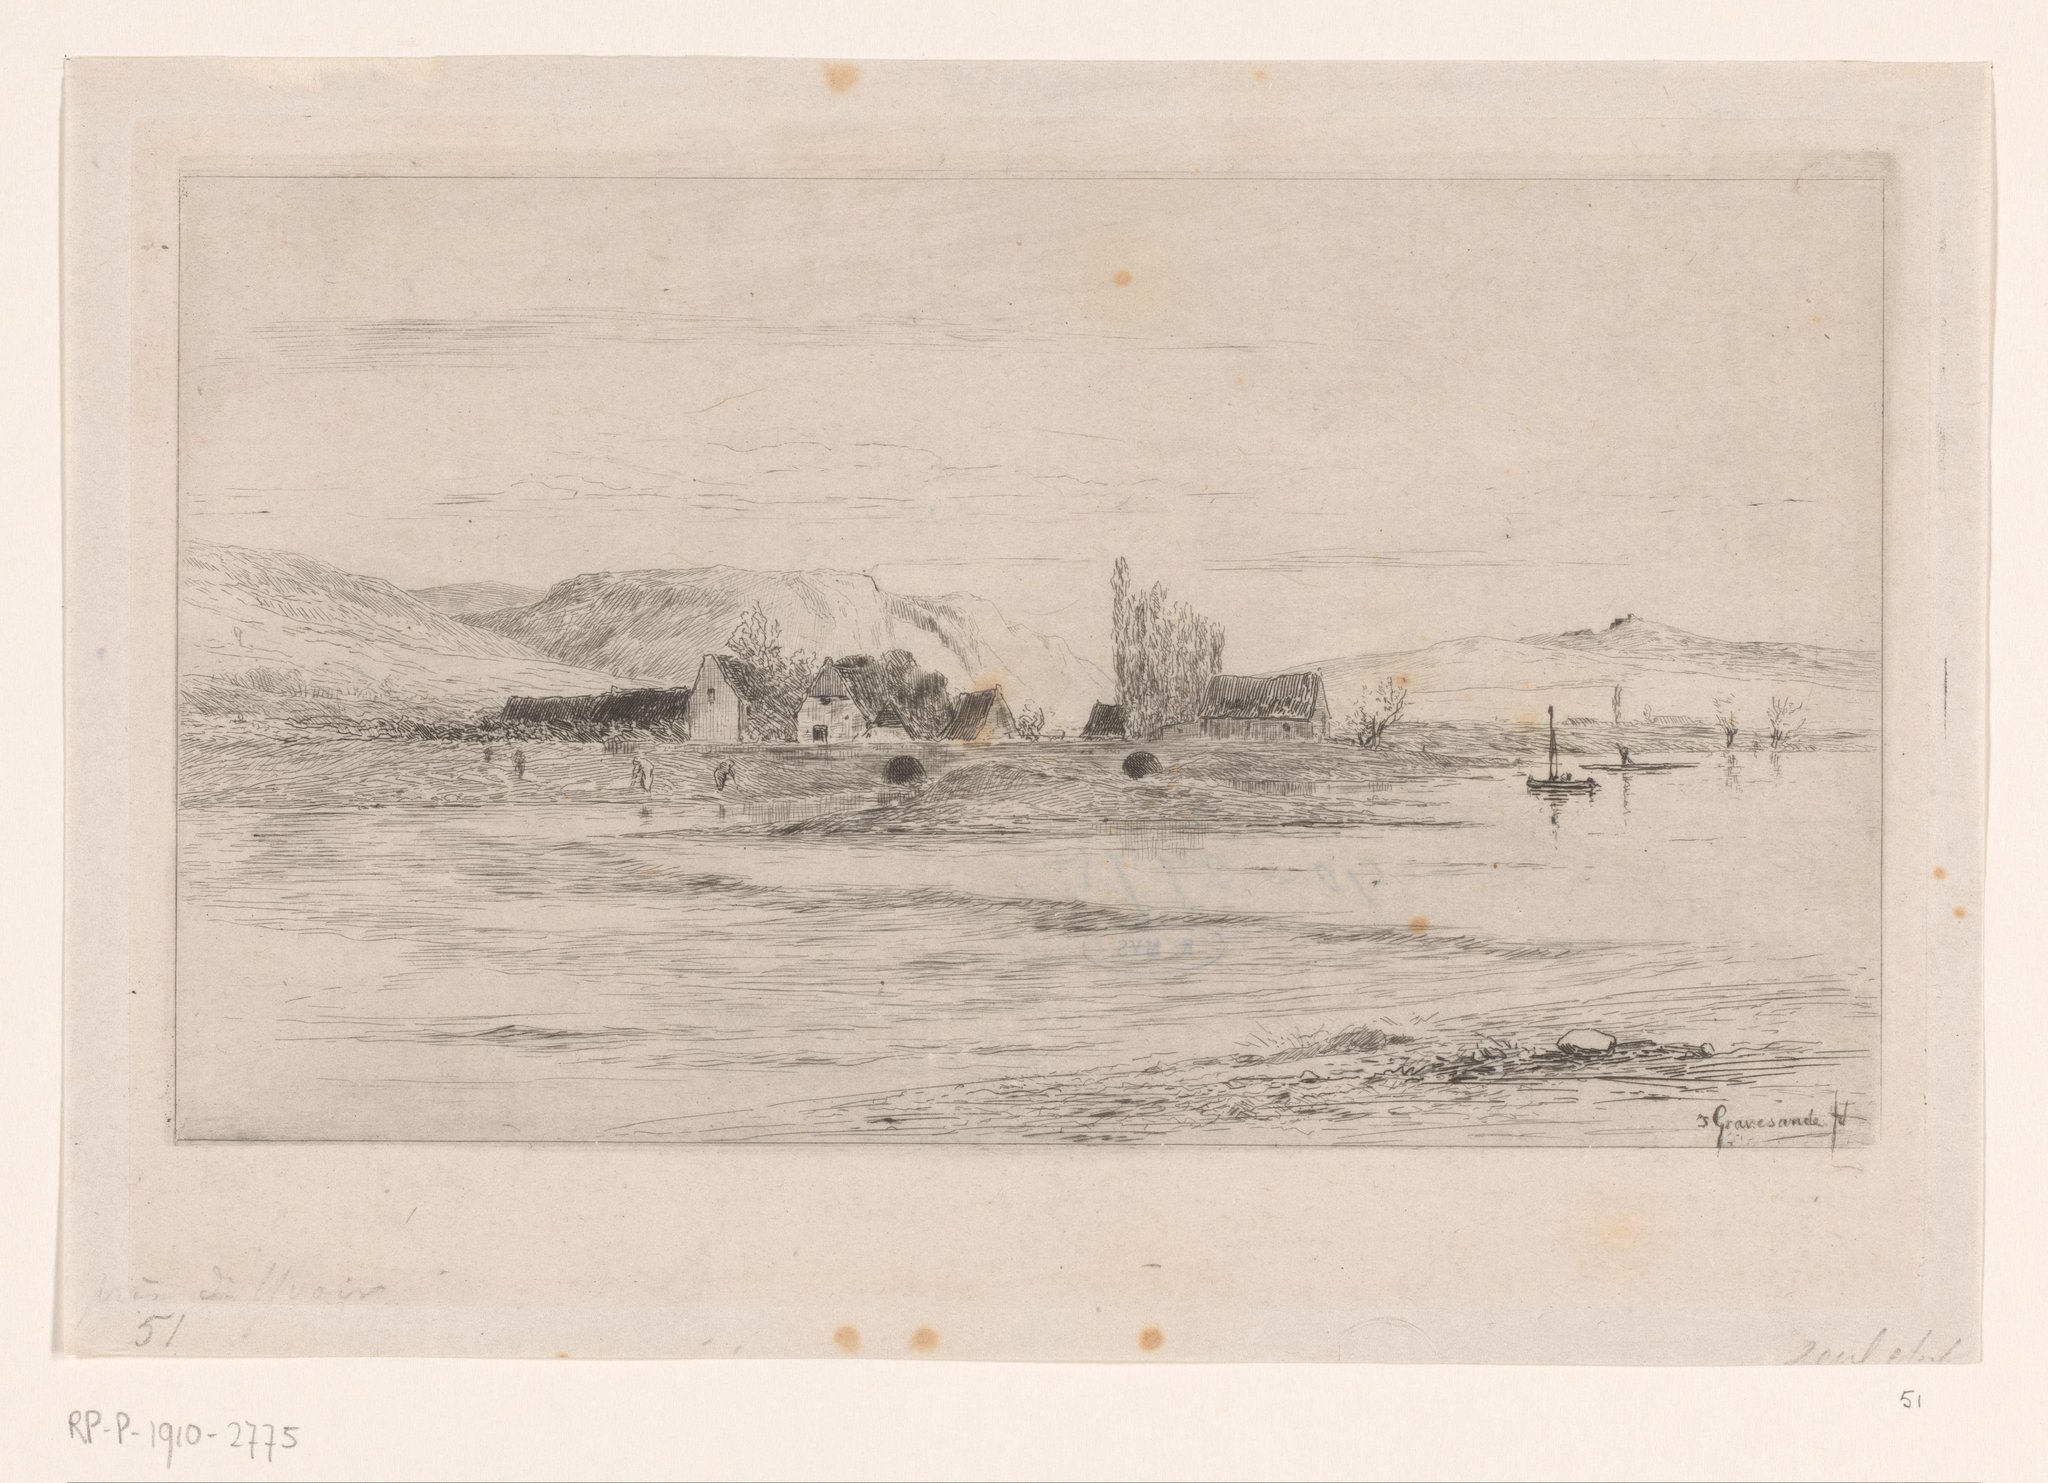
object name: print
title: Gezicht op Yvoir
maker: carel nicolaas storm van s-gravesande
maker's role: draughtsman, print maker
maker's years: 1841-1924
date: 1851-1910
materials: paper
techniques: etching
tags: prospect of village, silhouette of village, river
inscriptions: collector's mark: Lugt 2228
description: Een heuvellandschap met het dorp Yvoir en op de voorgrond de Maas.